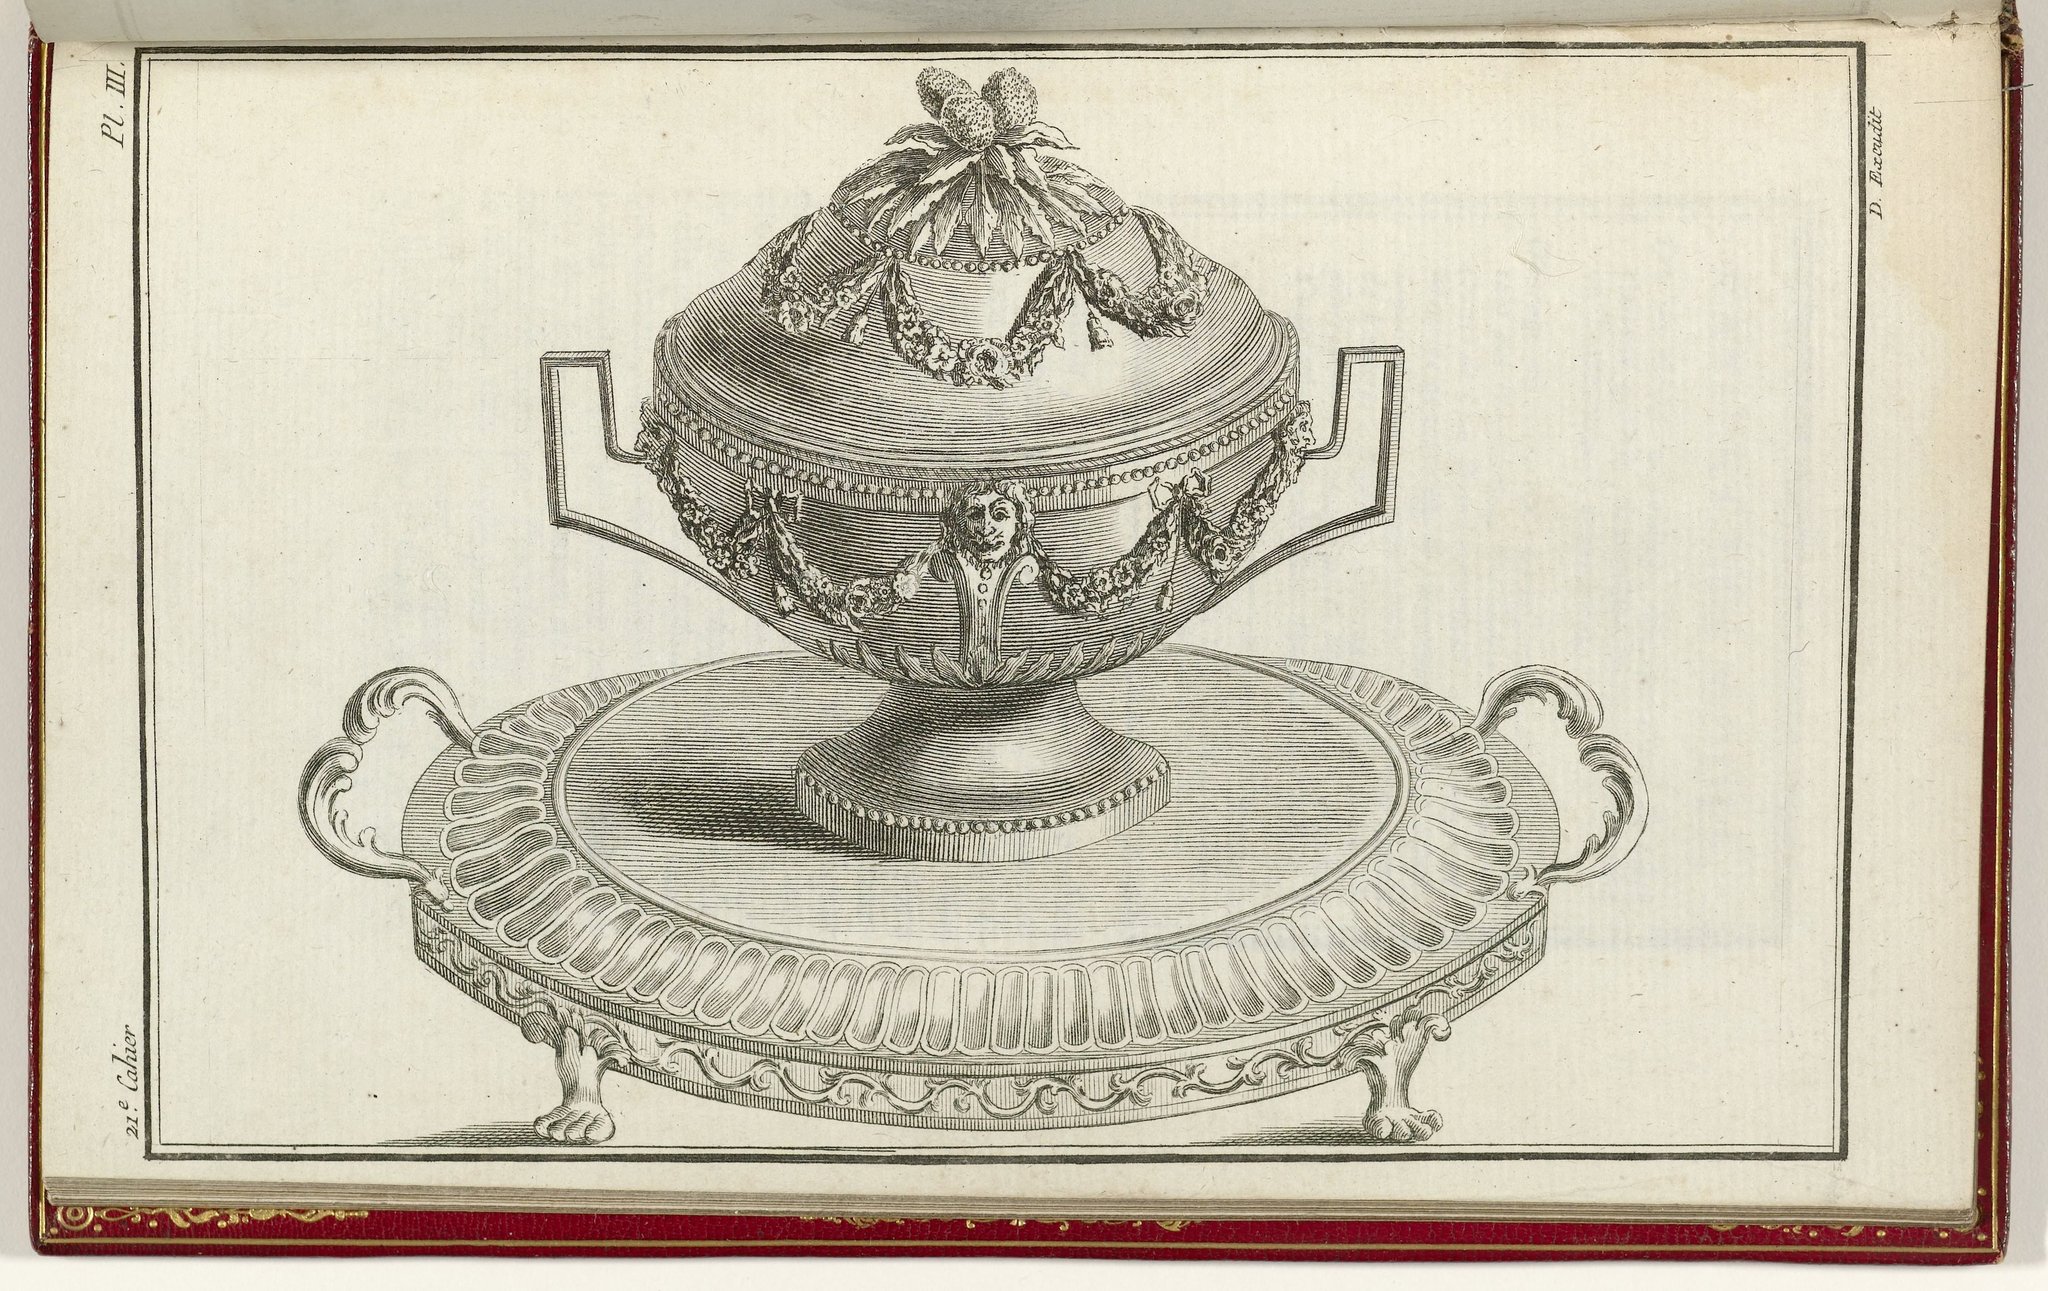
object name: print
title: Cabinet des Modes ou les Modes Nouvelles, 15 Septembre 1786, pl. III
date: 1786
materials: paper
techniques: engraving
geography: paris